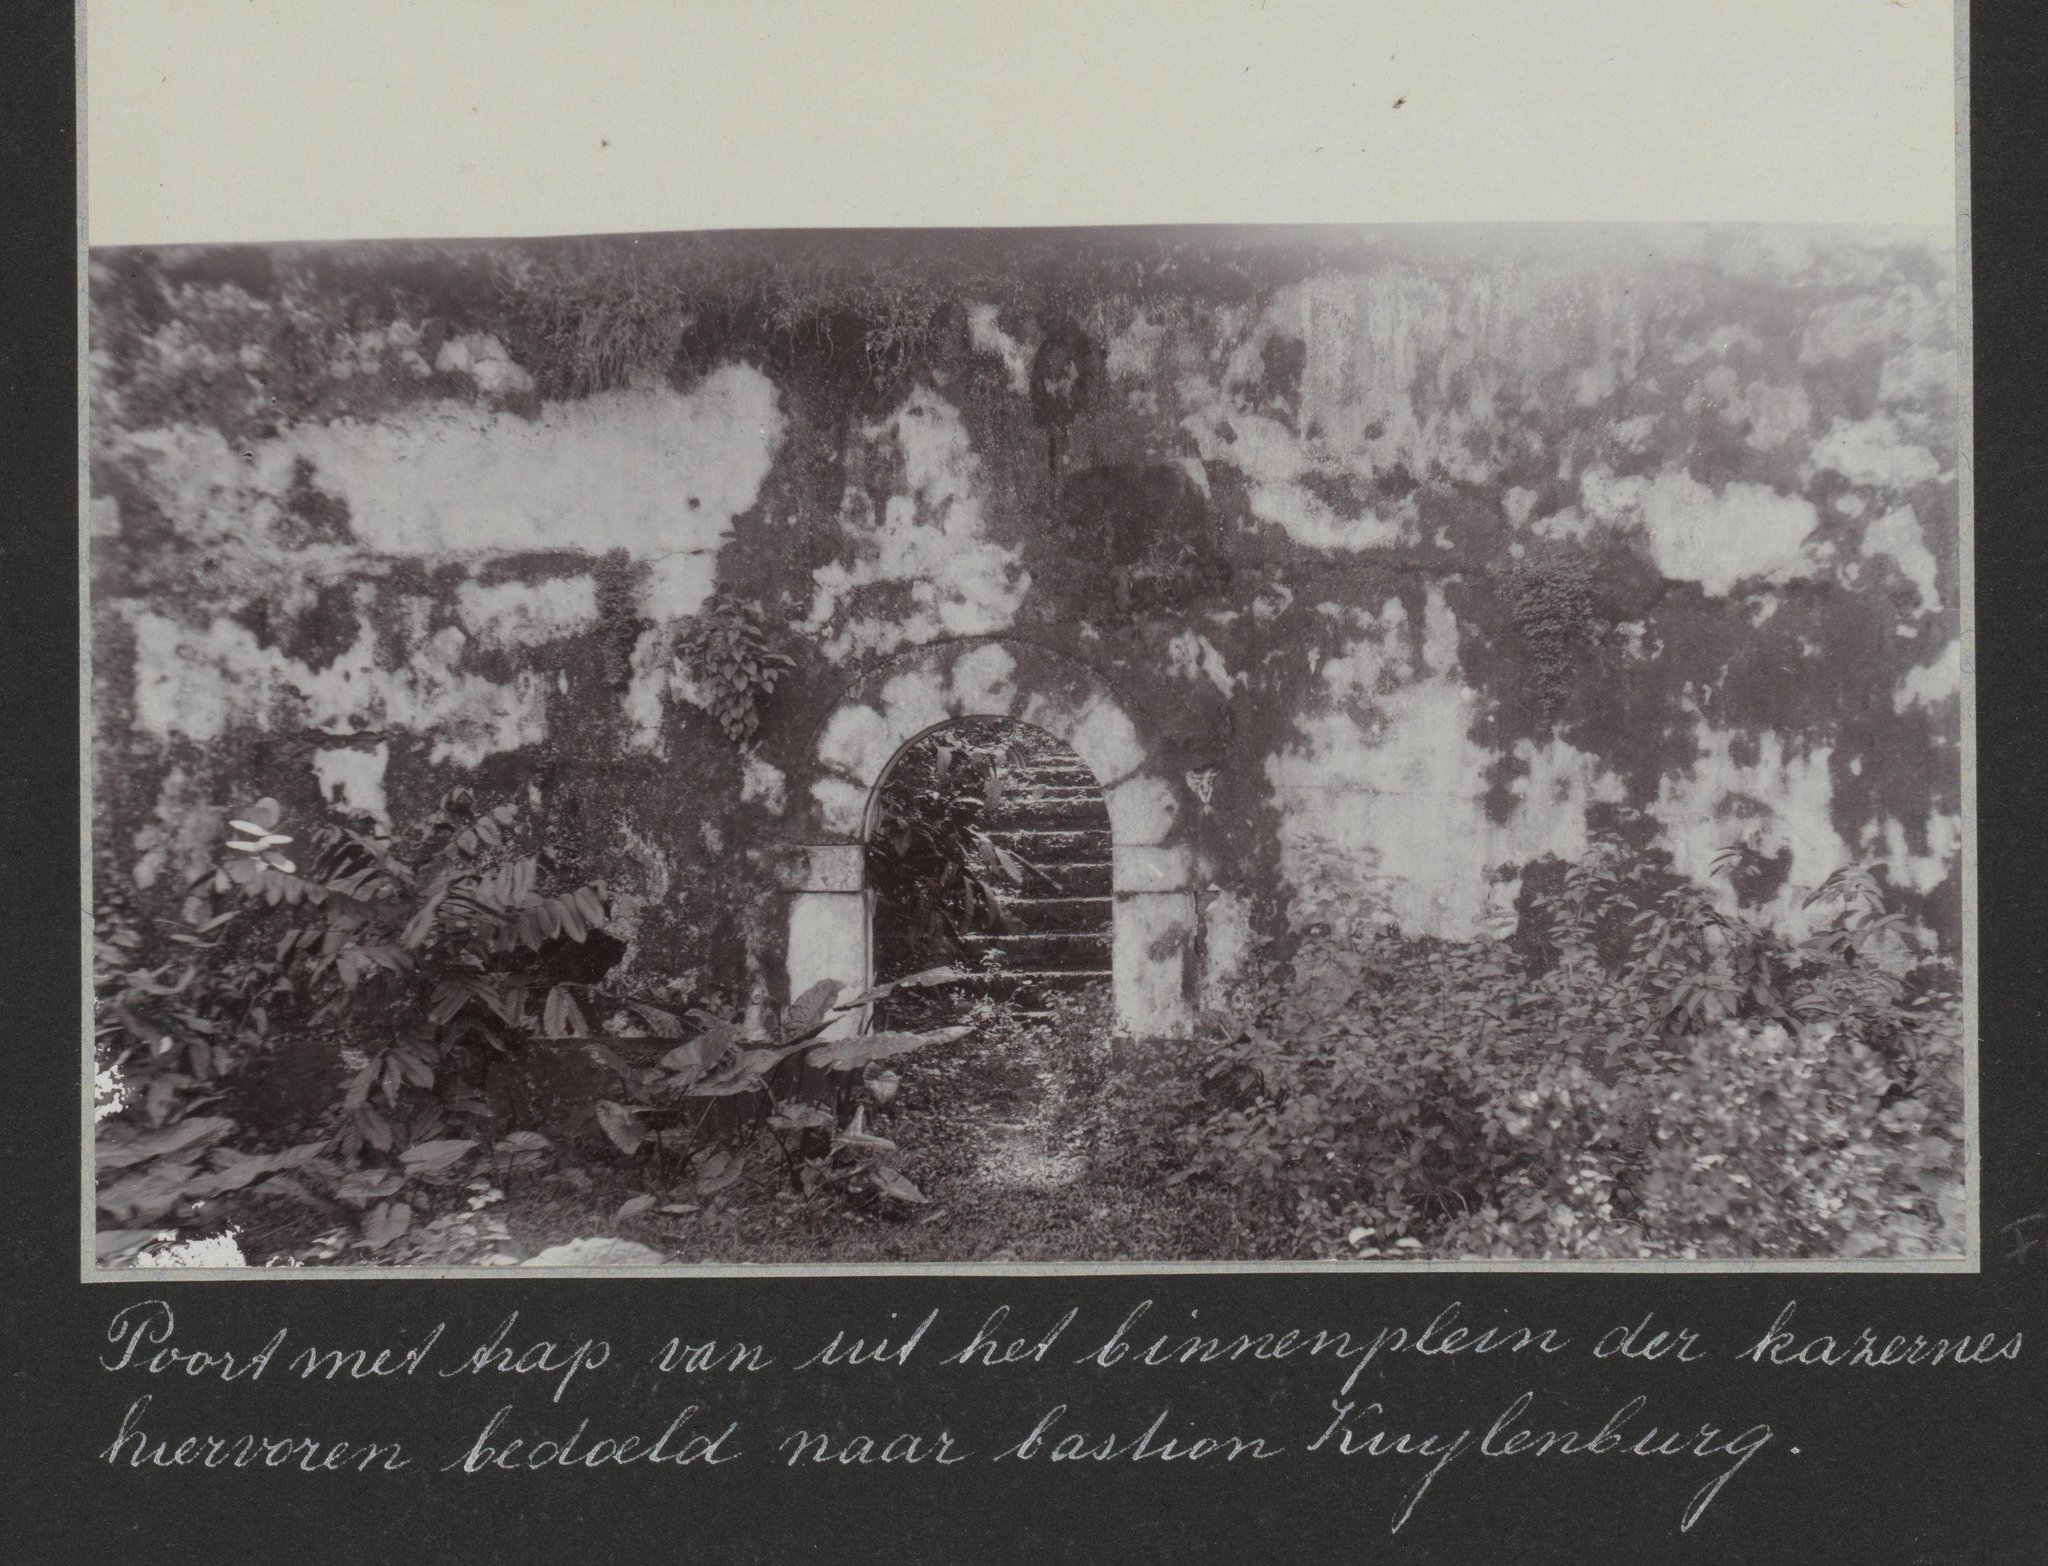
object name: album leaf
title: Verbindingspoort en trap van het binnenplein van de oude kazernes in Batavia naar het zuidelijk bastion Kuylenburg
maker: Anonymous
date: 1920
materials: paper, photographic support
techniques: gelatin silver print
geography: batavia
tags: gate, entrance, dutch east indies, the, batavia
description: Onderdeel van Reisalbum met foto's van Batavia.